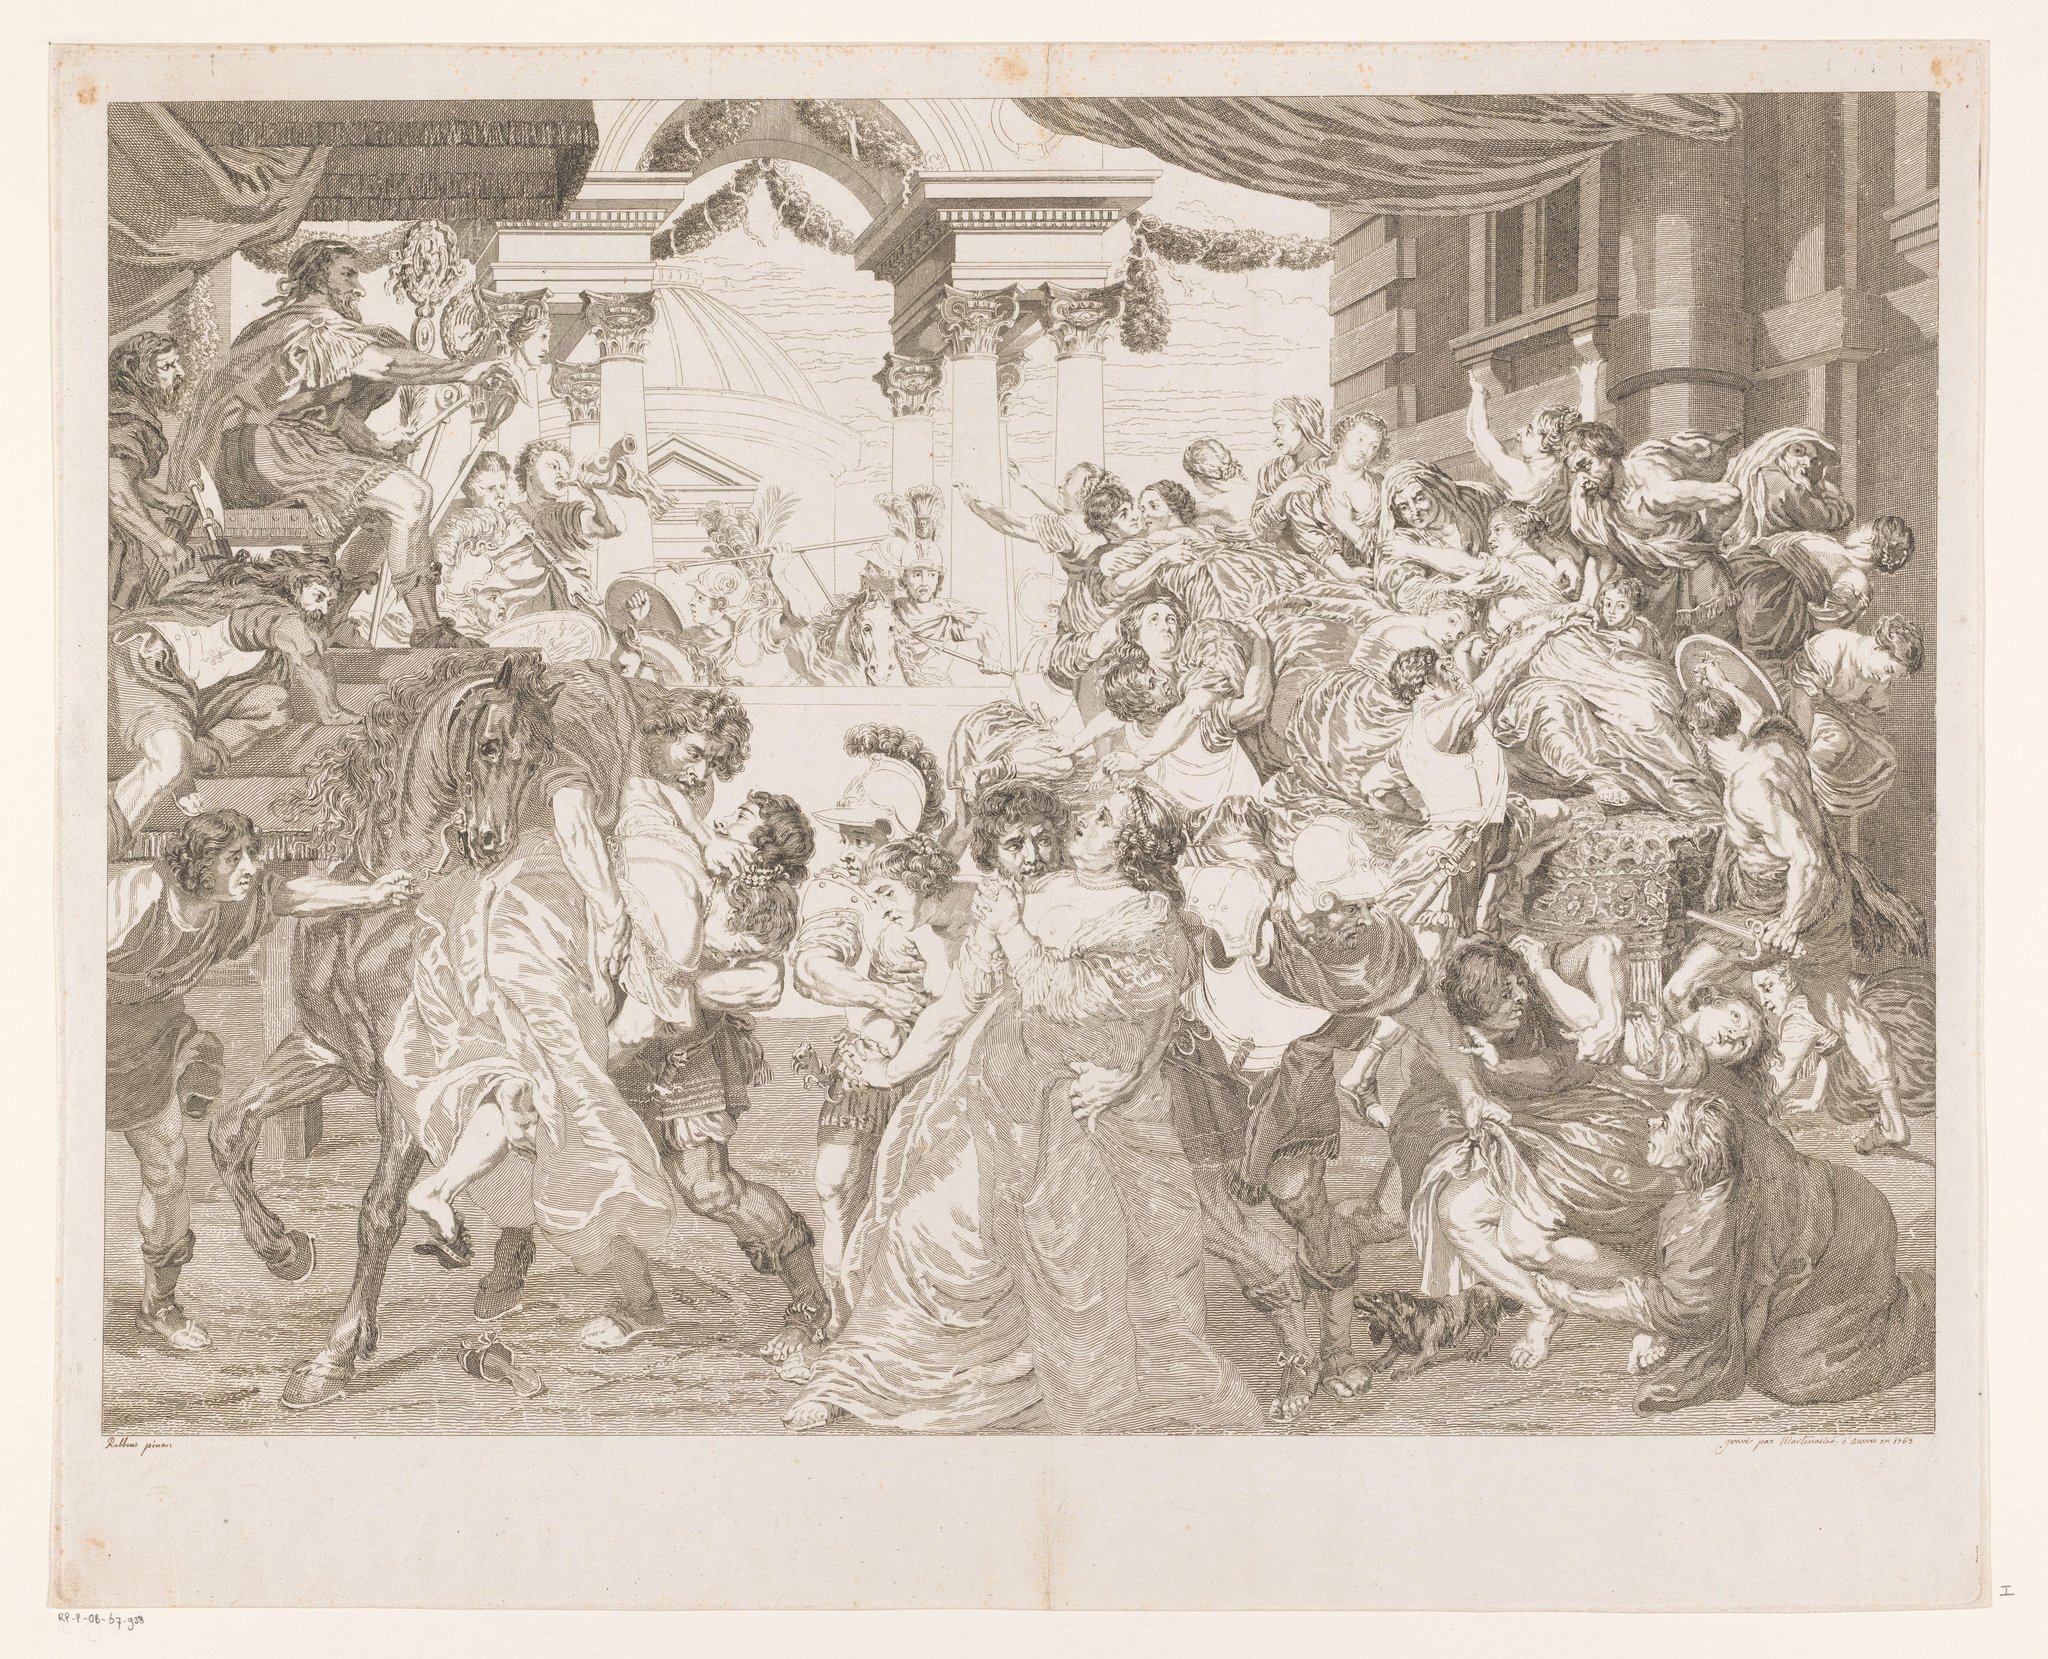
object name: print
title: Sabijnse maagdenroof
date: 1763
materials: paper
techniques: etching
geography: antwerp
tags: rape of the sabine women: they are carried off by romulus and his men during a feast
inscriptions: collector's mark: Lugt 240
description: Romulus, links onder een baldakijn, geeft opdracht de dochters van de Sabijnen te roven.